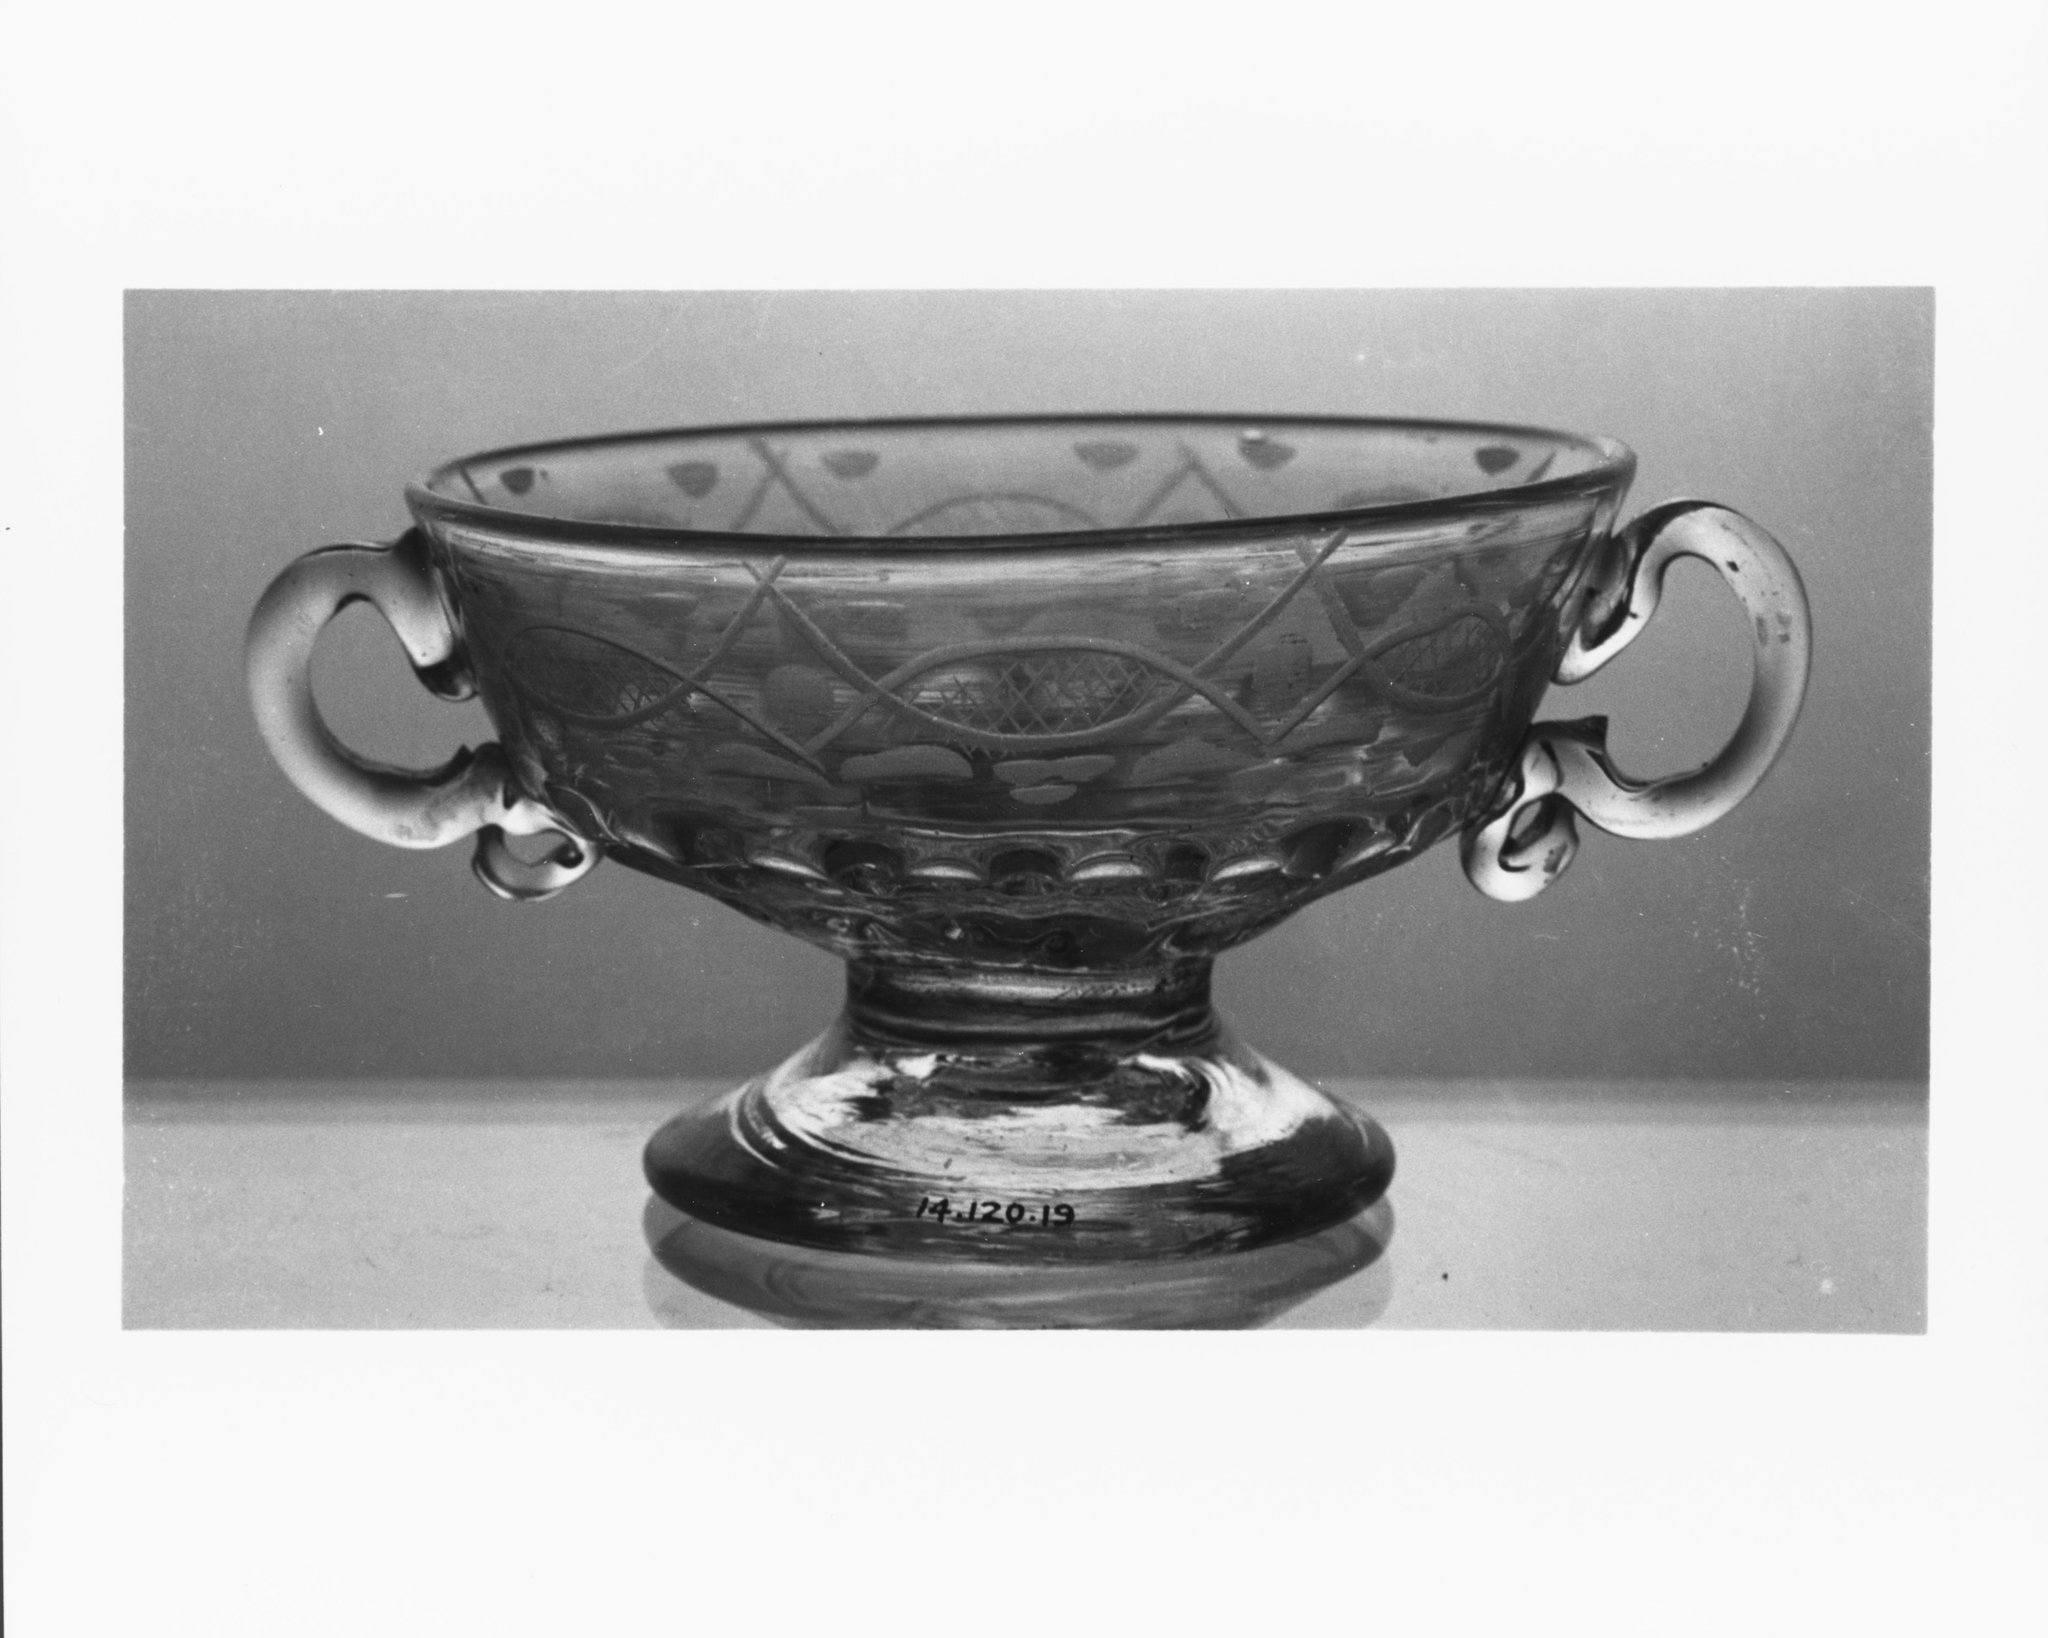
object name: bowl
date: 1775-1820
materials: glass, lead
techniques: engraving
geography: czech republic